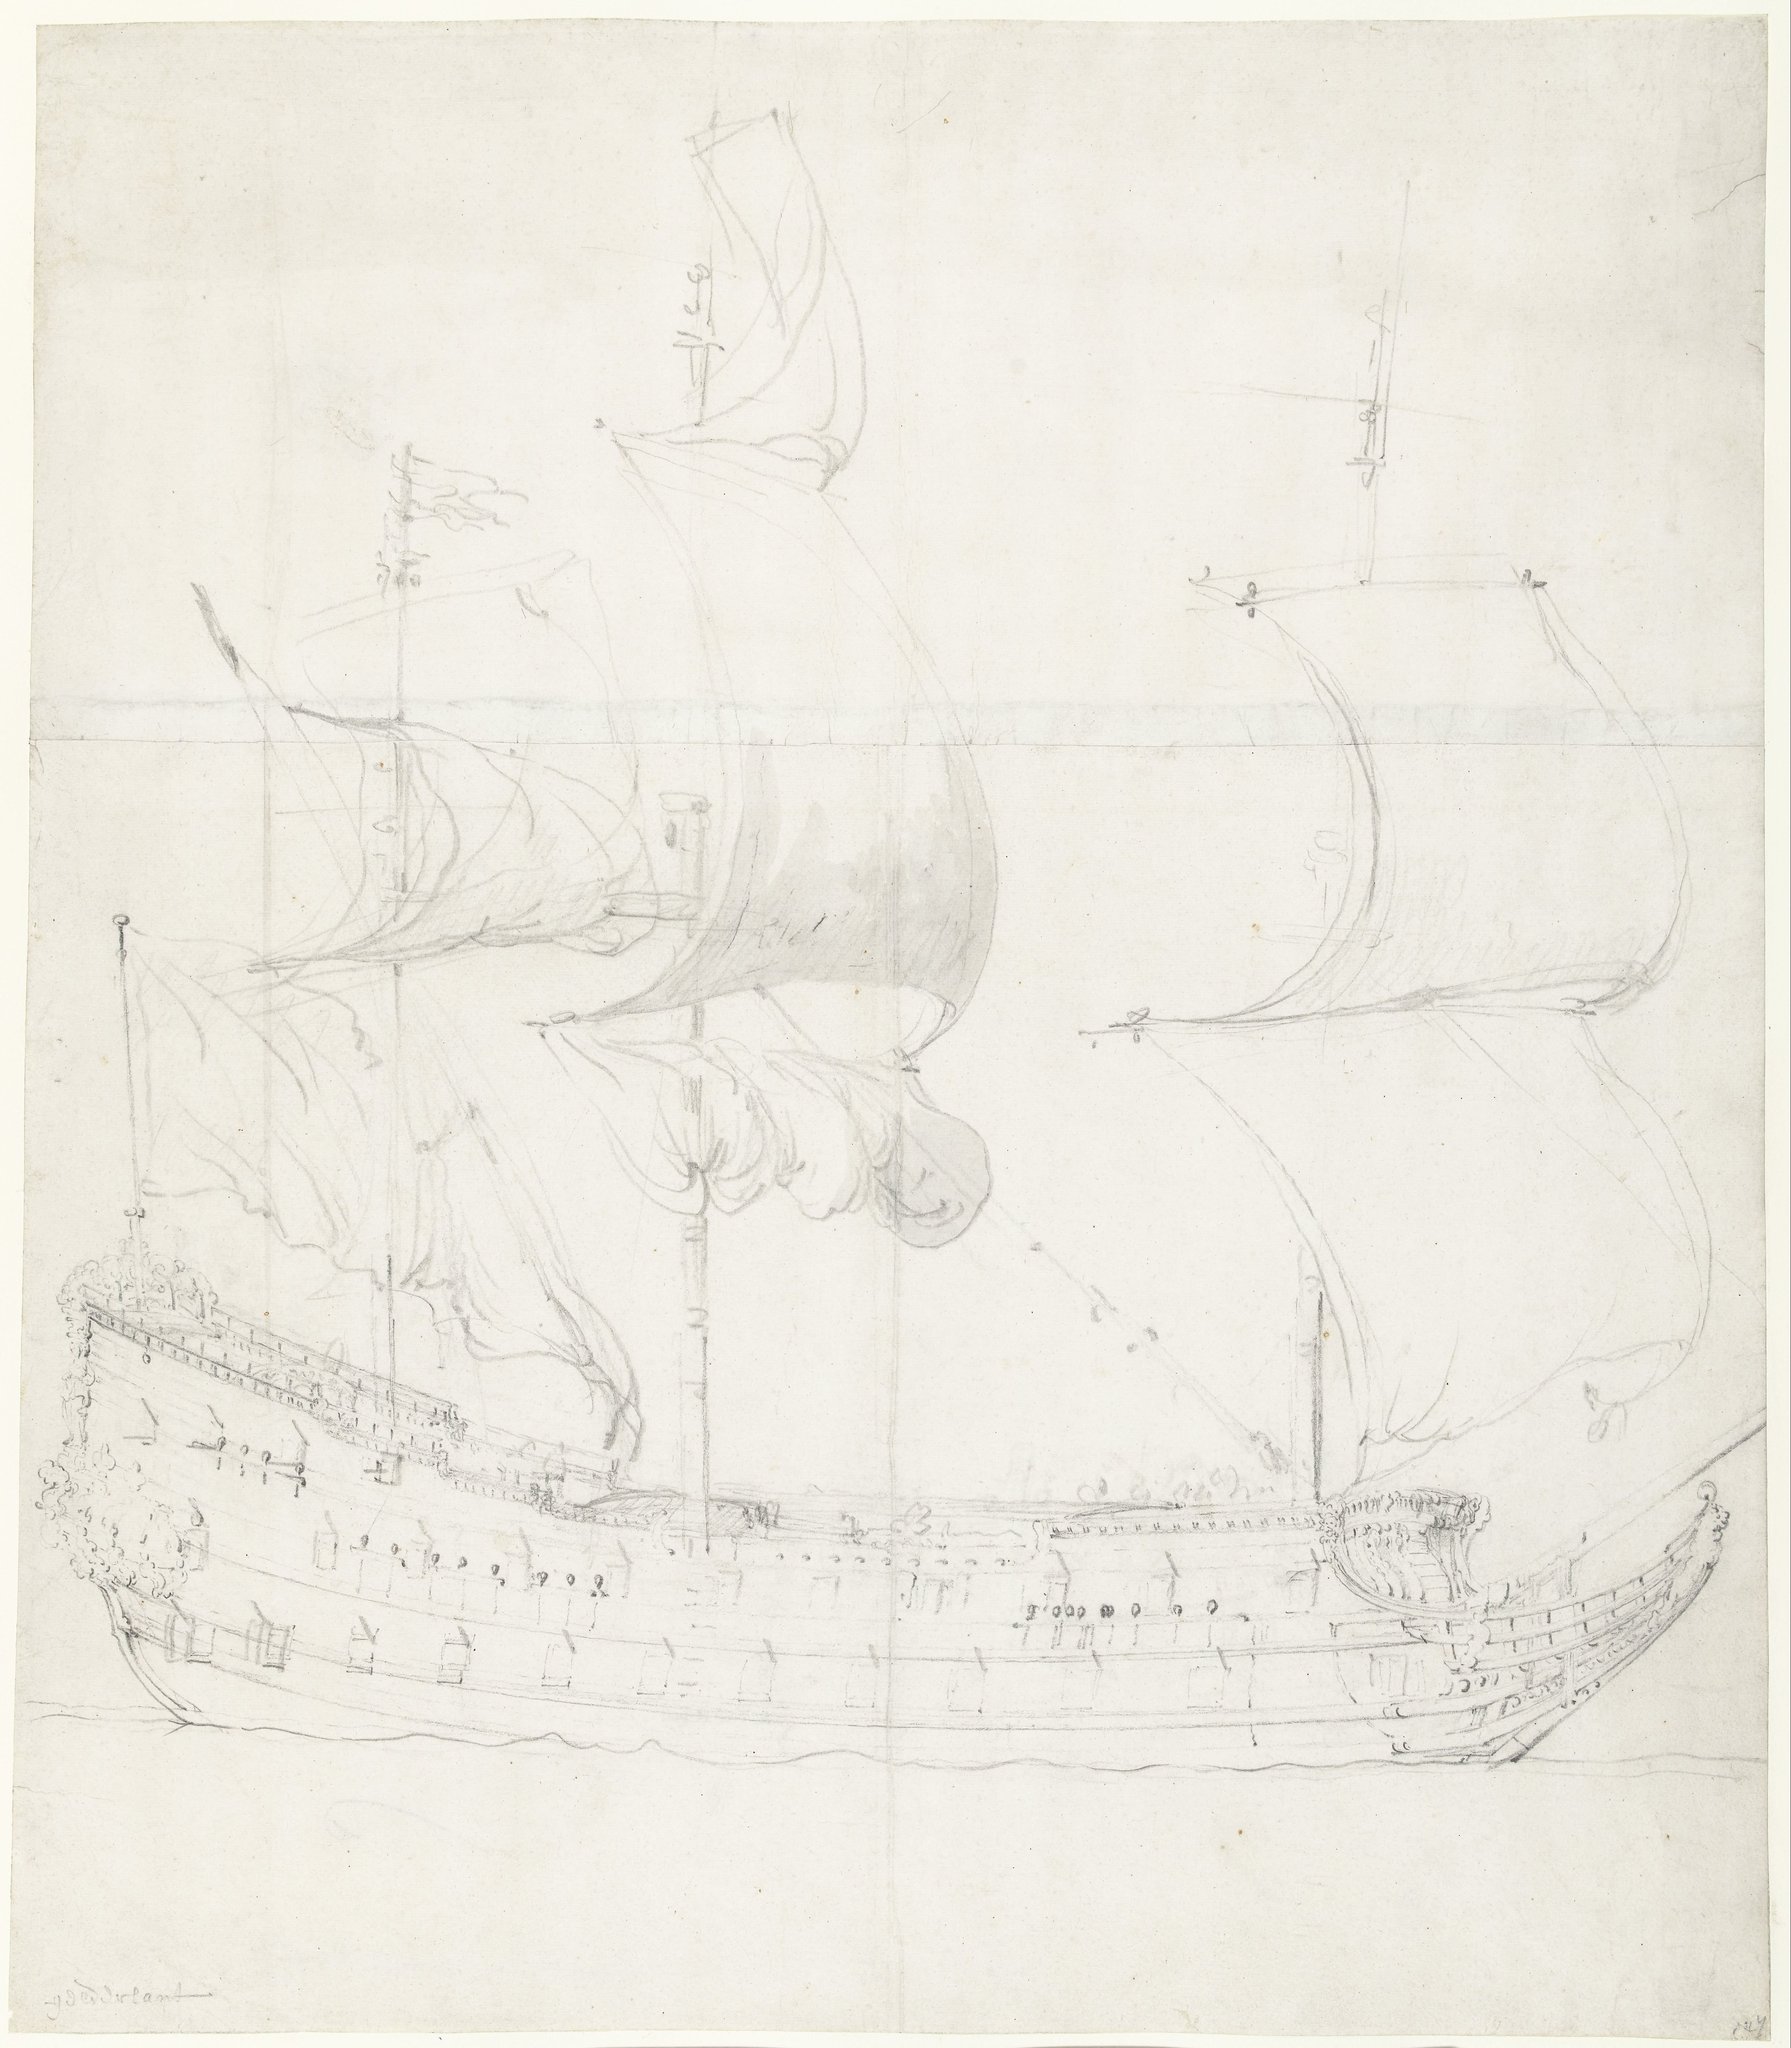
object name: drawing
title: Schip de Gelderland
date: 1683-1707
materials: chalk, paper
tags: sailing-ship, sailing-boat, names of artefacts and man-made objects (buildings excluded), navy (+ sailing-ships)